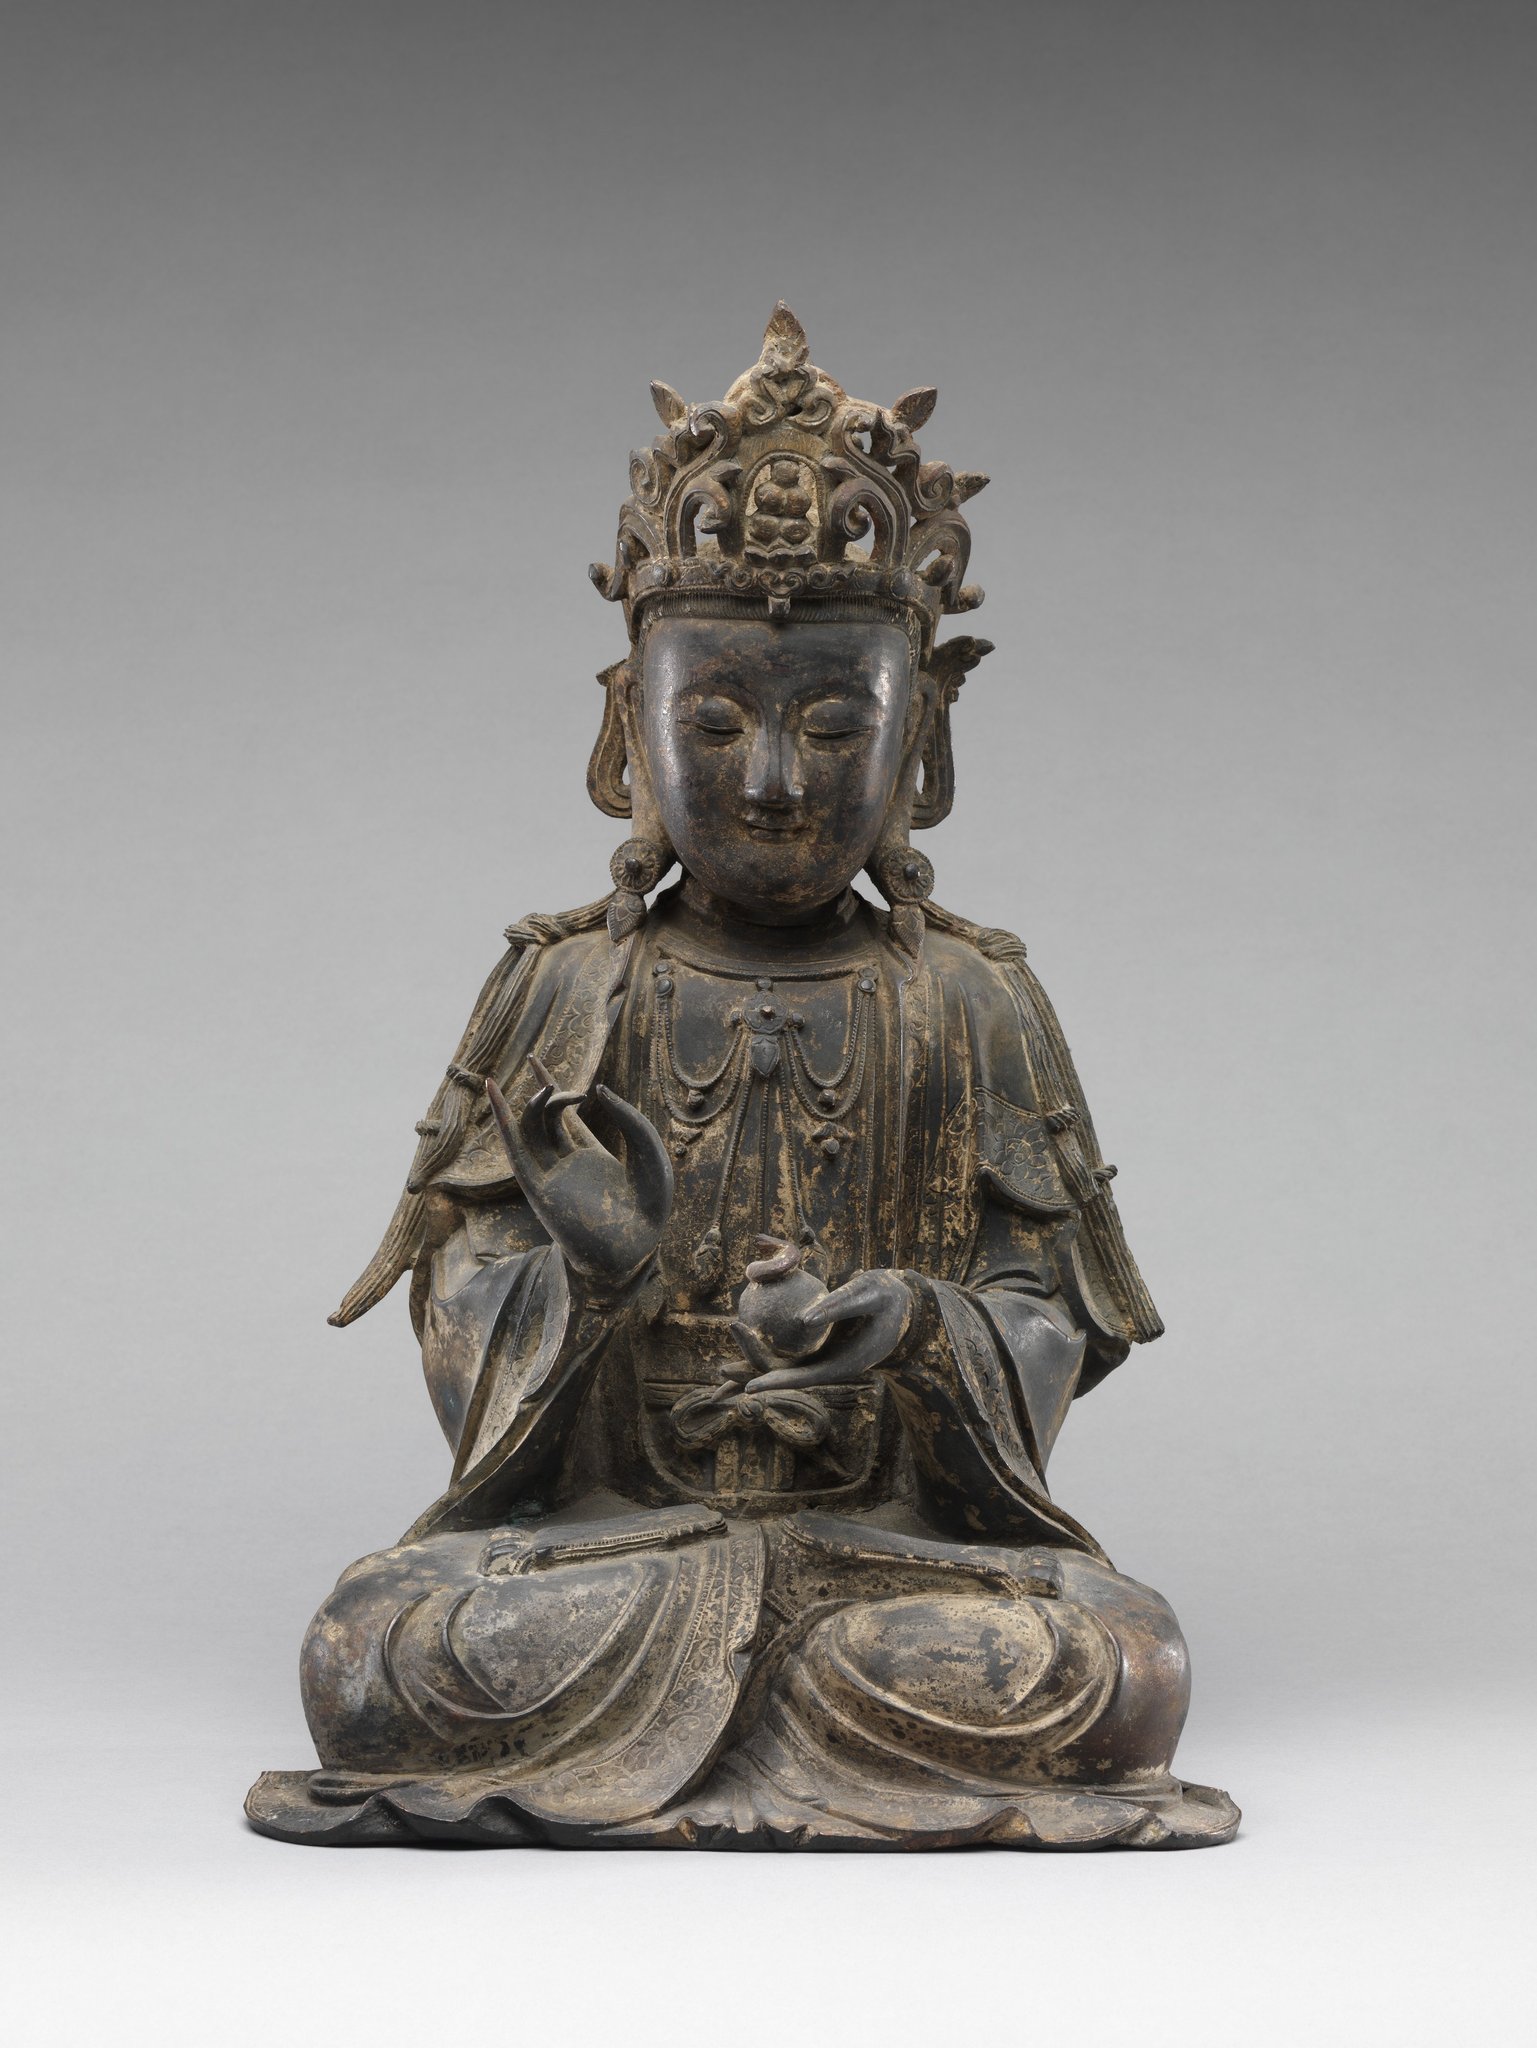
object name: figure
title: Bodhisattva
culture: chinese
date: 1401-1600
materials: gilt bronze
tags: bodhisattvas